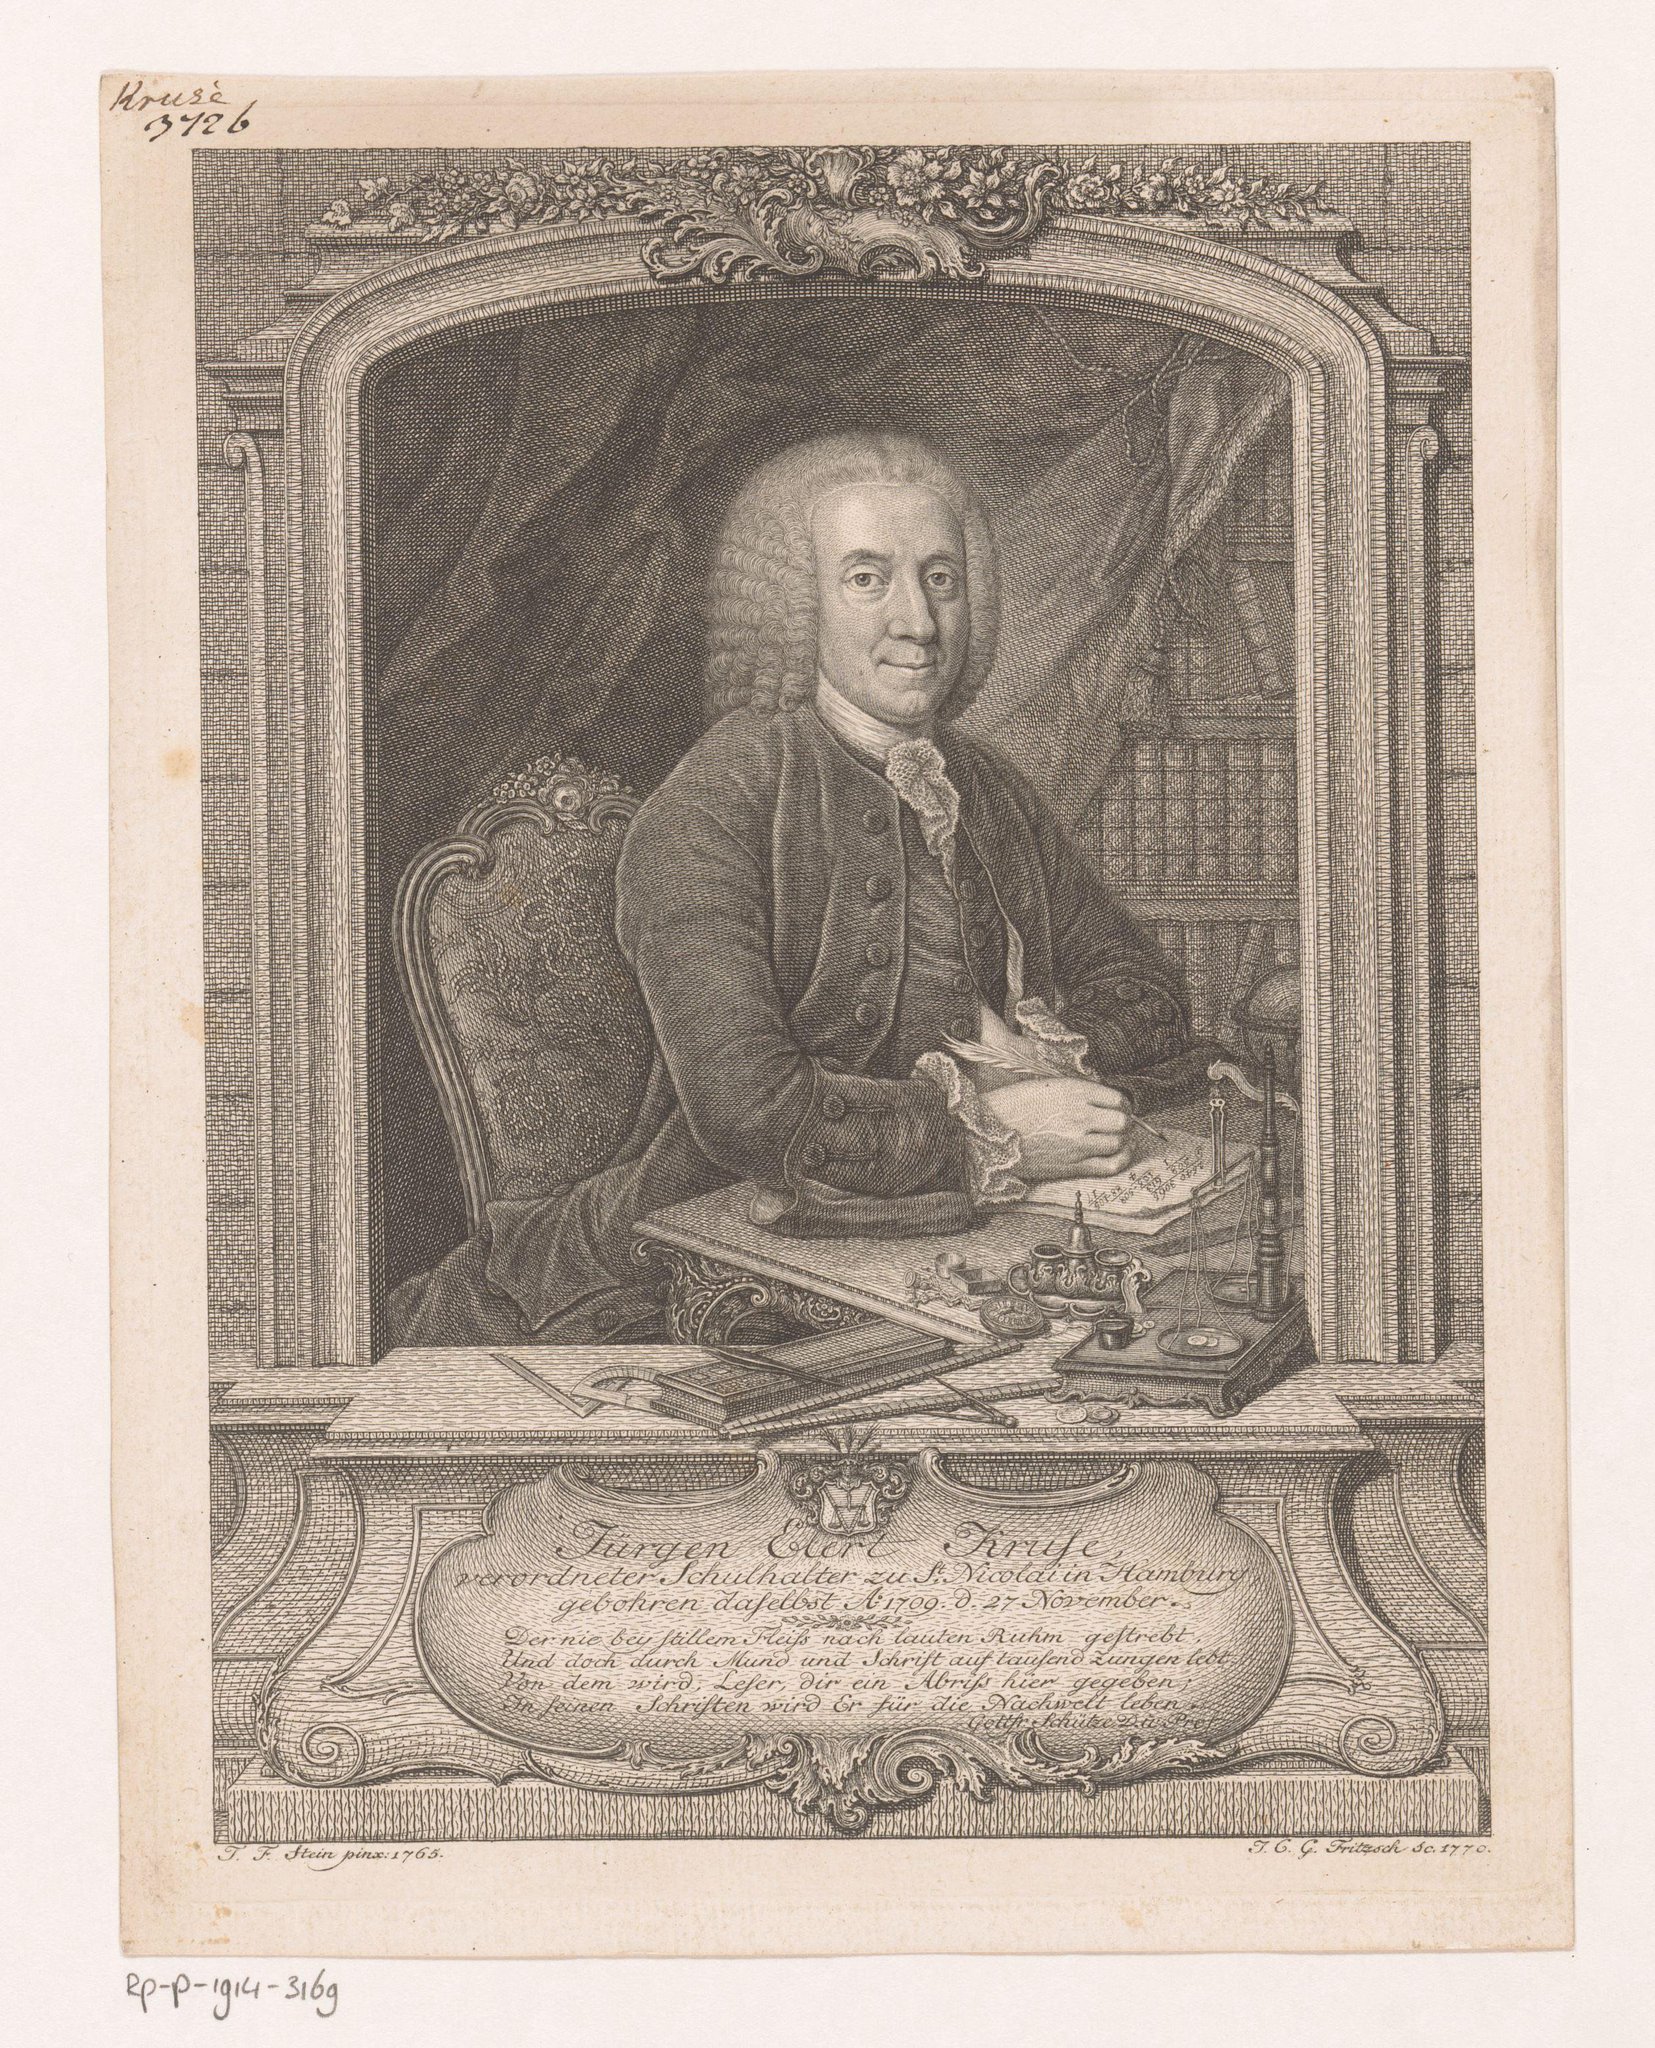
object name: print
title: Portret van Jürgen Elert Kruse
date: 1765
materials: paper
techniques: engraving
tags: bookshelves, rocaille ornament, writing tools, historical persons, scales, measuring-instruments, armorial bearing, heraldry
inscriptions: collector's mark: Lugt 2228